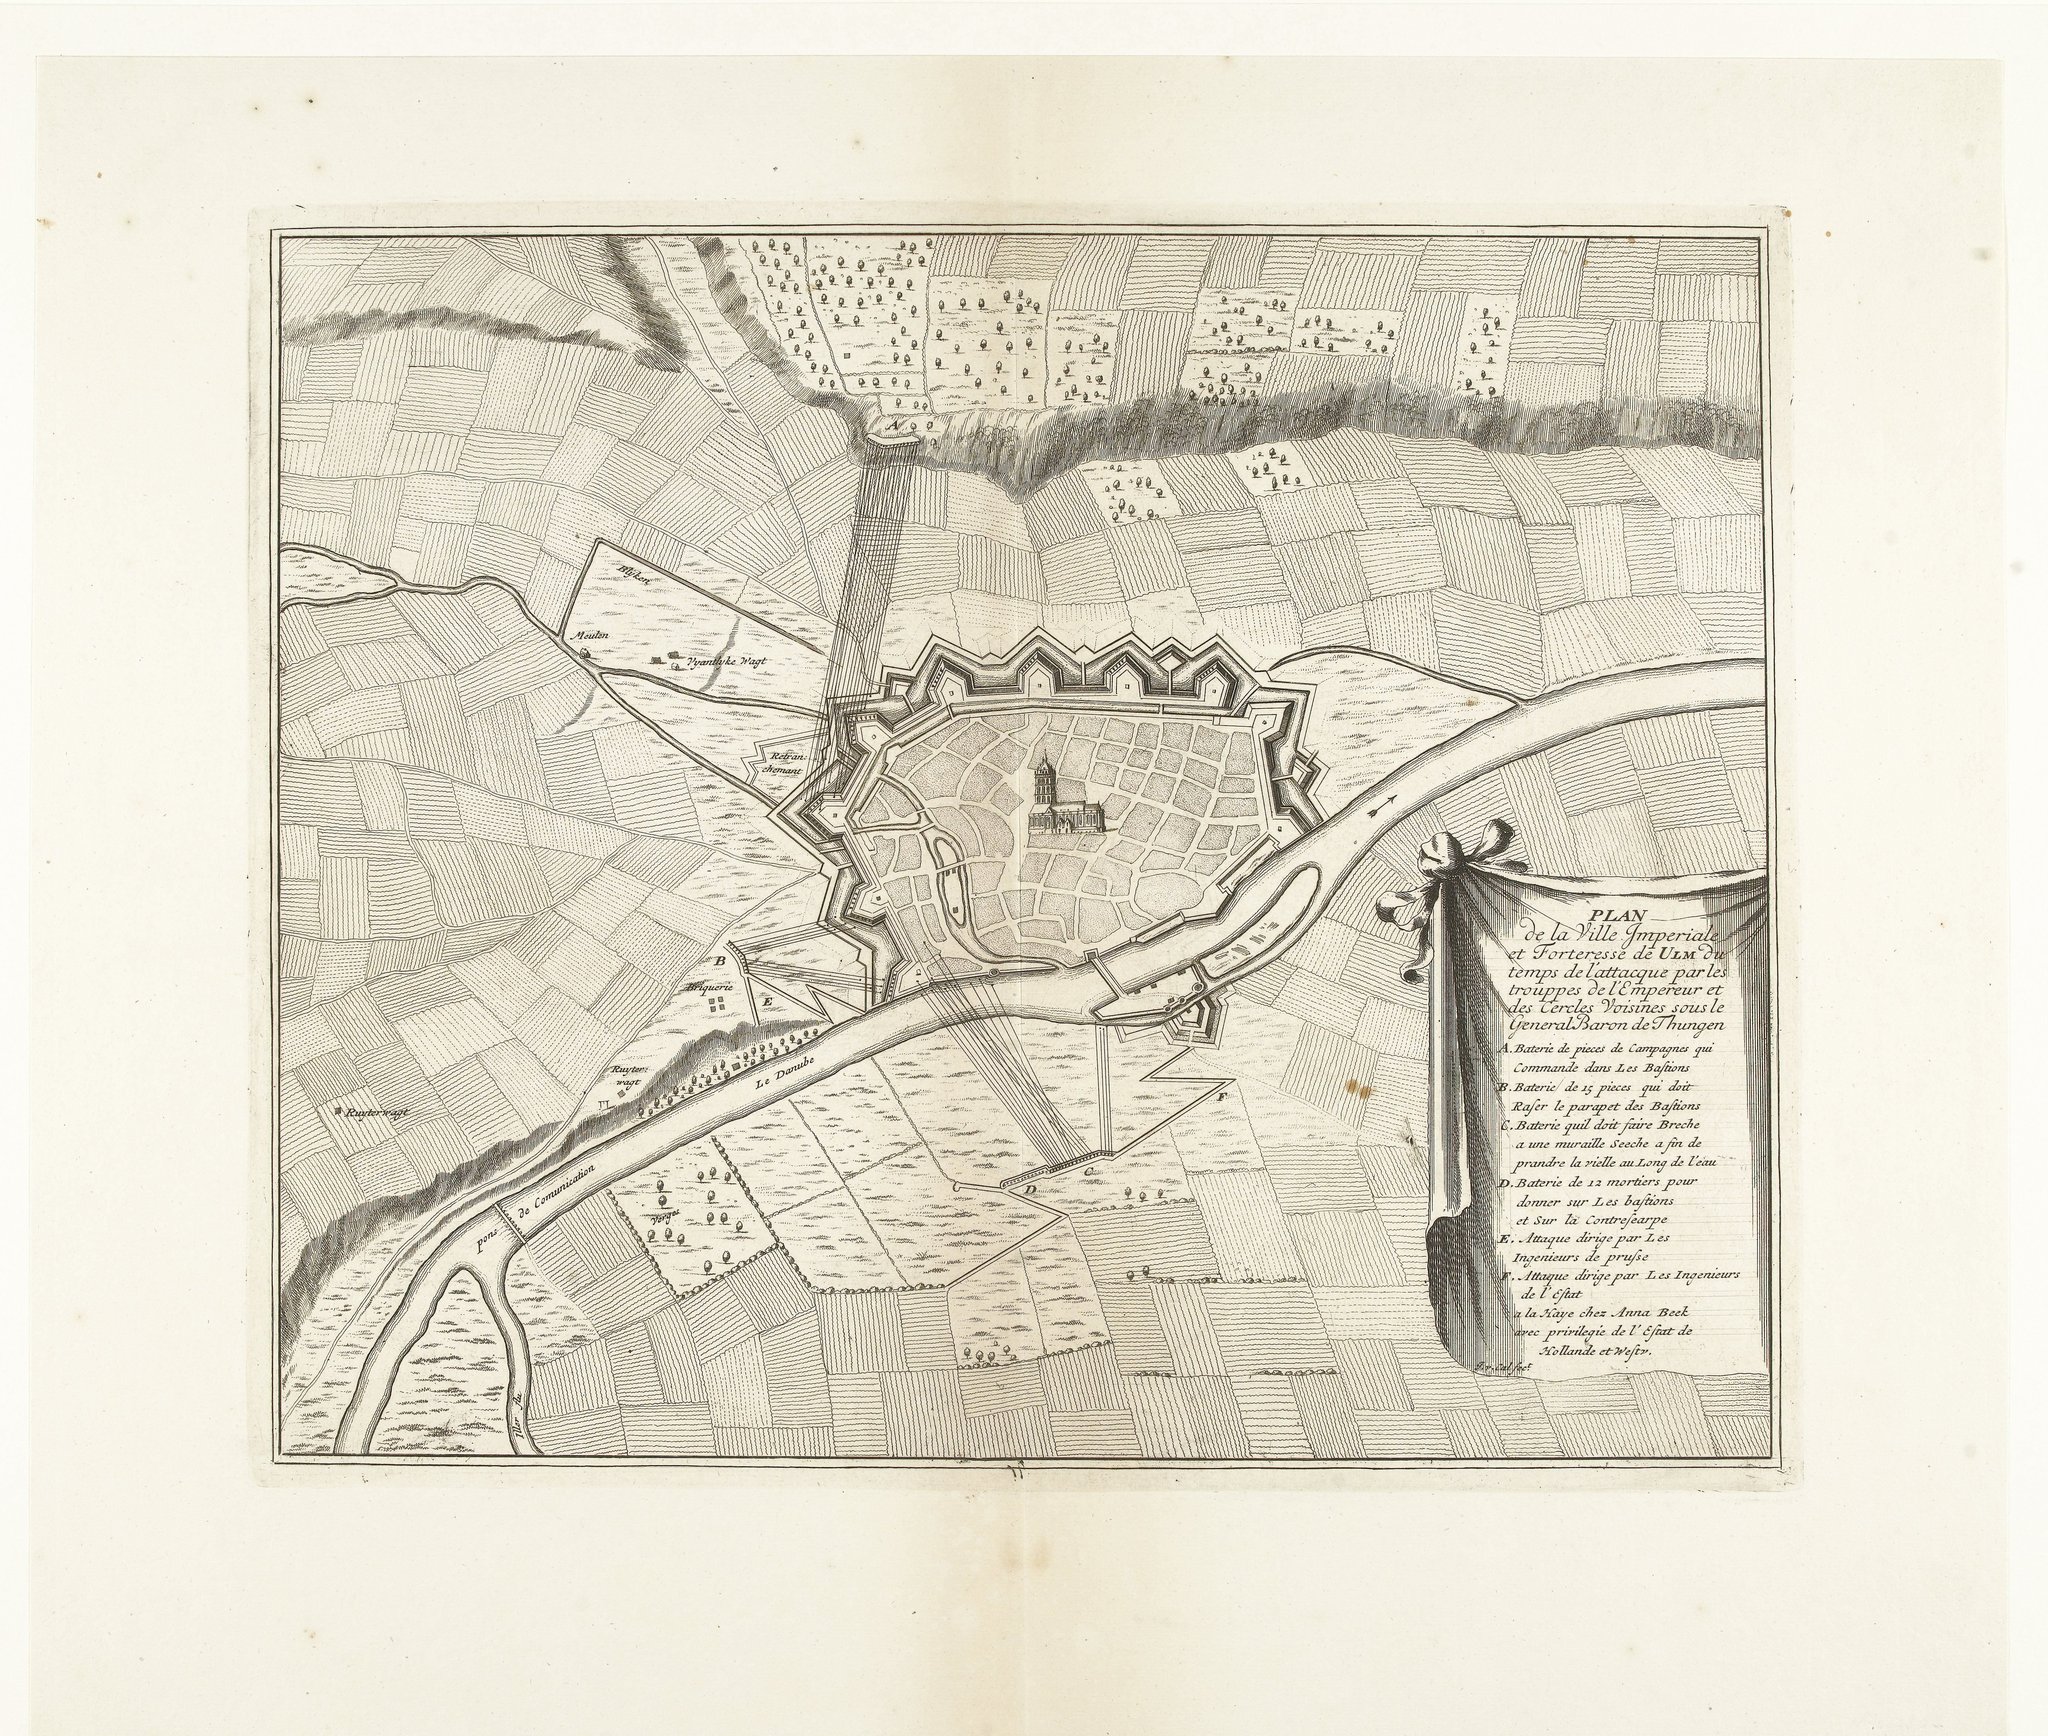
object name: map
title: Plan de la Ville Imperiale et Forteresse de Ulm du temps de l'attacque par les trouppes de l'Empereur (...)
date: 1704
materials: paper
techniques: etching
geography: northern netherlands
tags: siege, position war, maps of cities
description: Plattegrond van Ulm, belegerd door de keizerlijke troepen en ingenomen op 13 september 1704.